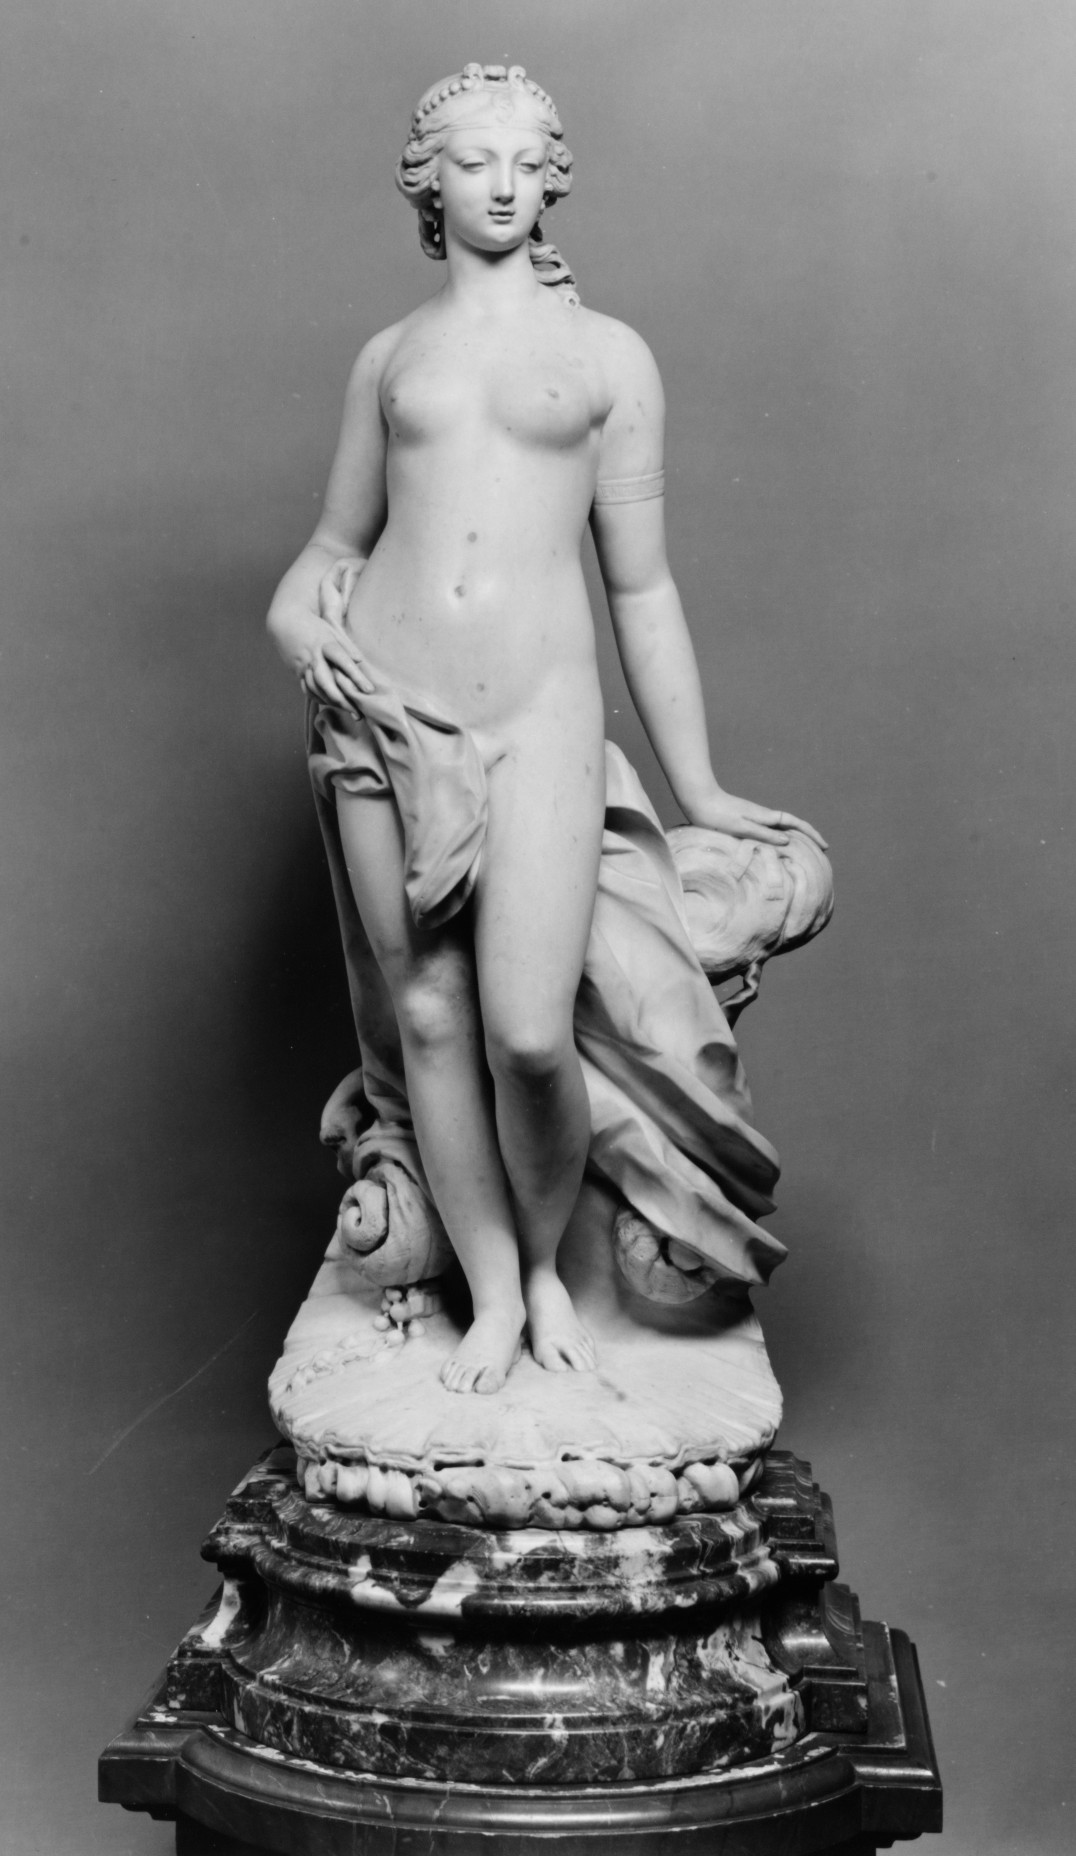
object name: statuette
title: Venus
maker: claude desbatisse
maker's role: artist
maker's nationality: french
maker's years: 1661-1761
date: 1701-1800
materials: marble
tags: venus